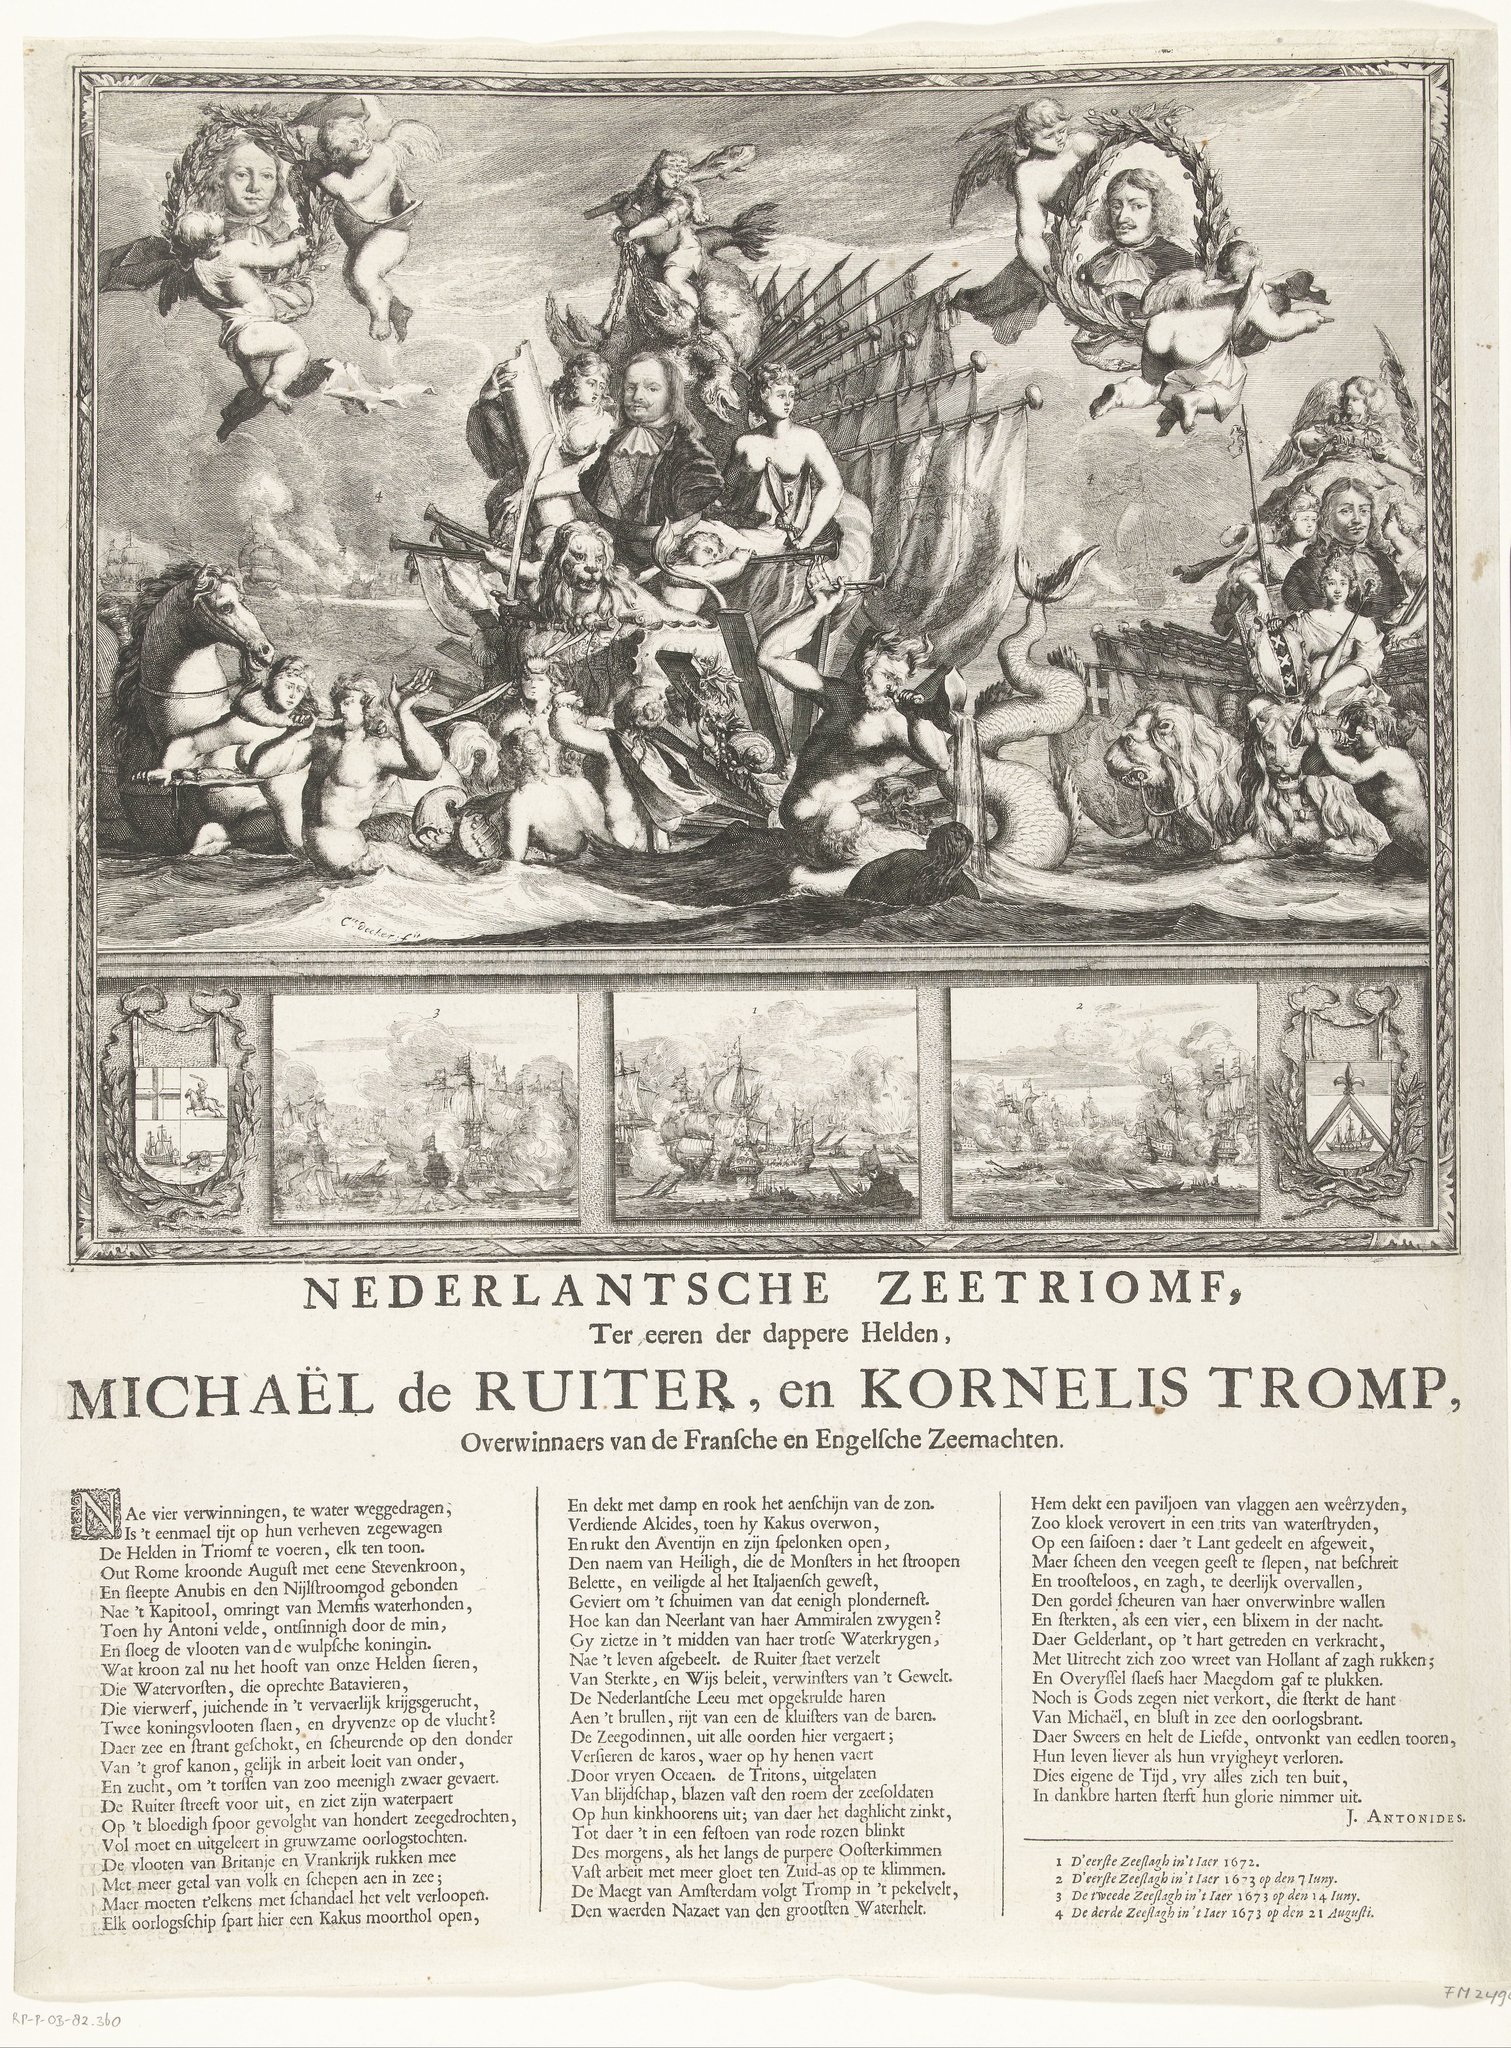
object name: print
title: Allegorie ter ere van Michiel Adriaenszoon de Ruyter en Cornelis Tromp en hun overwinningen in de zeeslagen in de jaren 1672 en 1673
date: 1673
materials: paper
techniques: engraving, etching, letterpress printing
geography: northern netherlands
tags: flushing, michiel adriaenszoon de ruyter, johan de liefde, rotterdam, amsterdam, cornelis tromp, nijmegen, battle (+ naval force), symbolic triumphs of individual persons, battle of the texel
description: Allegorie ter ere van Michiel Adriaenszoon de Ruyter en Cornelis Tromp en hun overwinningen in de zeeslagen in de jaren 1672 en 1673. De borstbeelden van De Ruyter en Tromp getrokken in zegewagens over het water door tritons, zeepaarden en zeeleeuwen. In de lucht putti met portretten van de tijdens de slag bij Kijkduin omgekomen bevelhebbers Isaac Sweers en Johan de Liefde. Op de achtergrond de slag bij Kijkduin op 21 augustus 1673. Met drie kleine voorstellingen van de eerdere zeeslagen en lofdicht in drie kolommen.